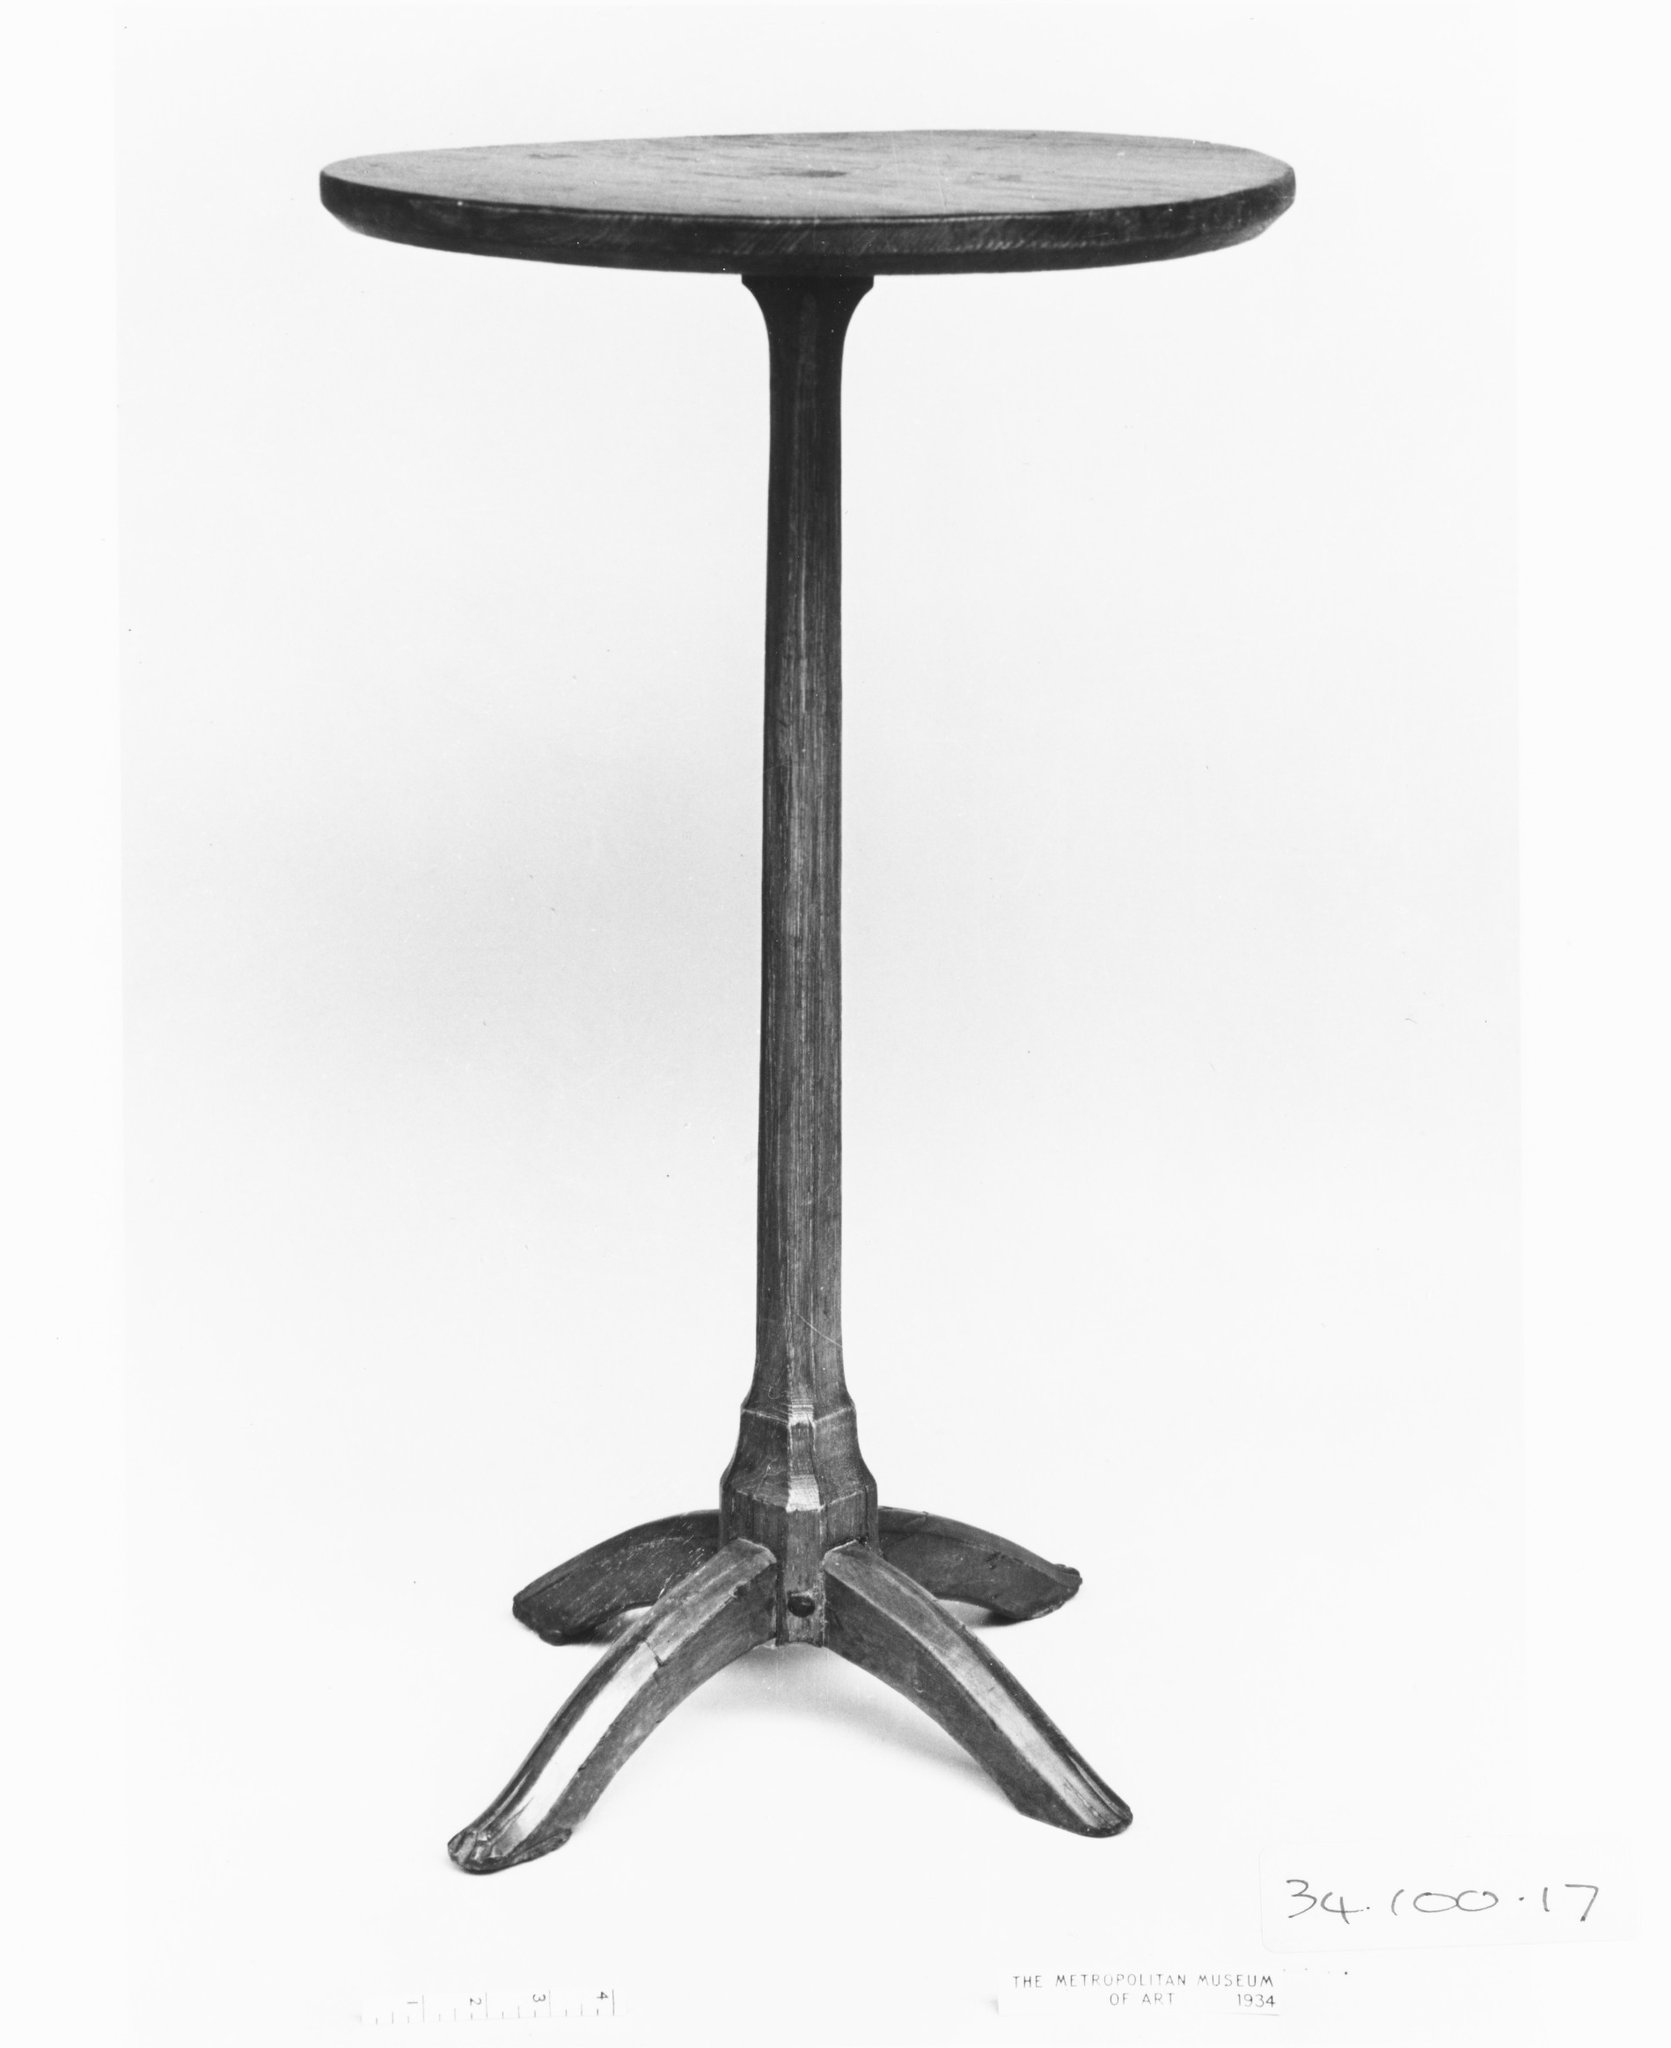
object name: candle stand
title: Candlestand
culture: american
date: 1725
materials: wood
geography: united states